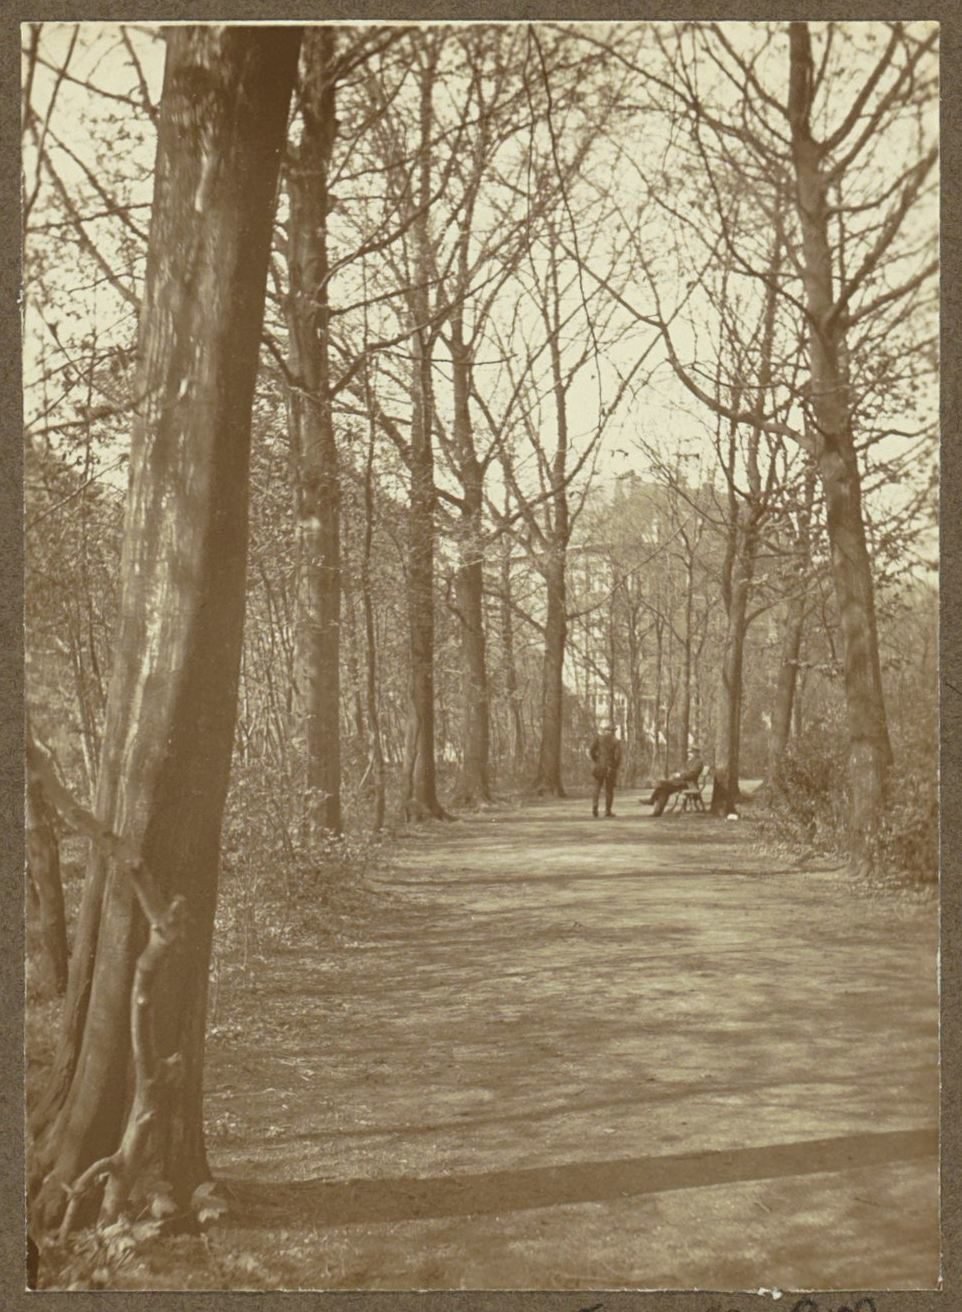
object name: photograph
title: Mannen op een wandelpad in het Amsterdamse Vondelpark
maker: Anonymous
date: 1910-1930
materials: paper, photographic support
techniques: gelatin silver print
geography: vondelpark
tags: public gardens, park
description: Onderdeel van Album met foto's van Amsterdam en omgeving.